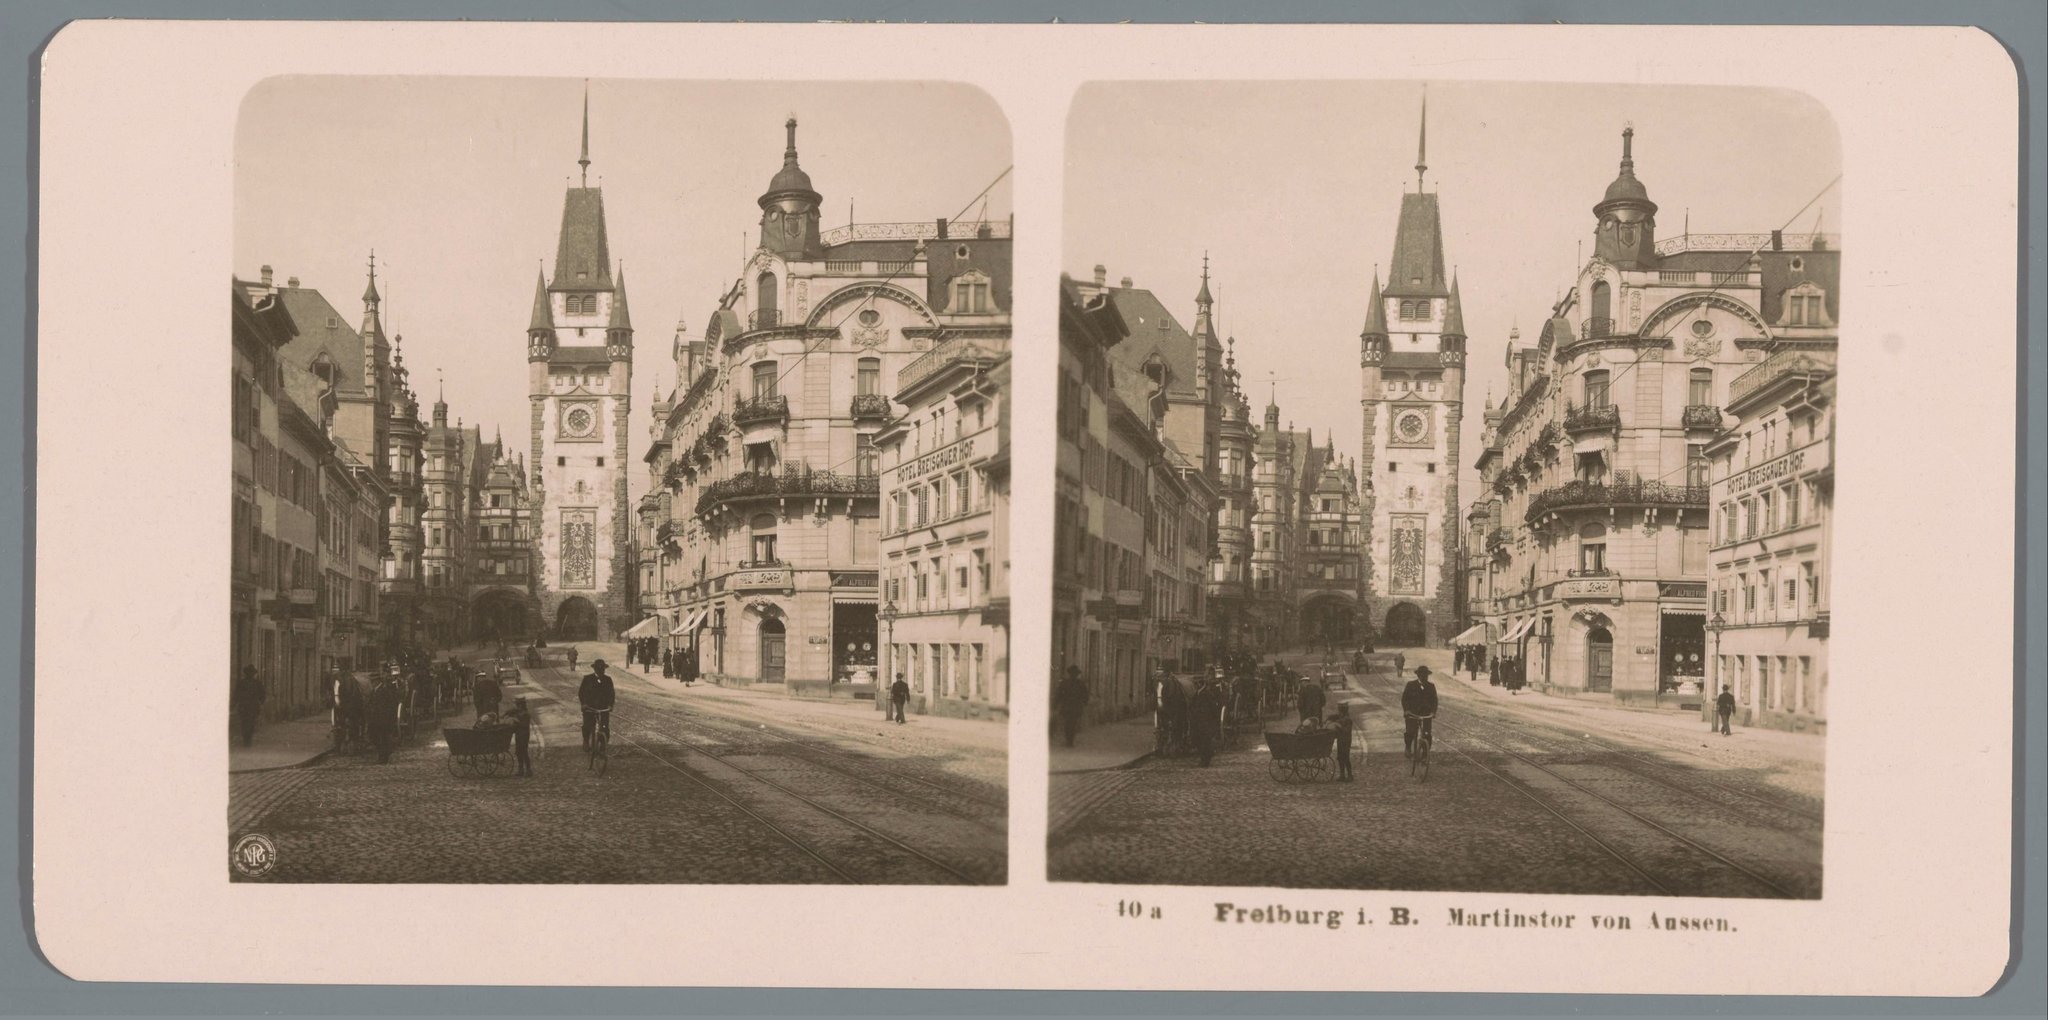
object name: stereograph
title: Freiburg I. Br. Martinstor von aussen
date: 1901-1910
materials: cardboard, photographic support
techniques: gelatin silver print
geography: freiburg im breisgau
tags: tower, clock tower ~ monumental adornment, façade (of house or building), street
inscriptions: number: ‘40 a’, inscription: ‘NPG’